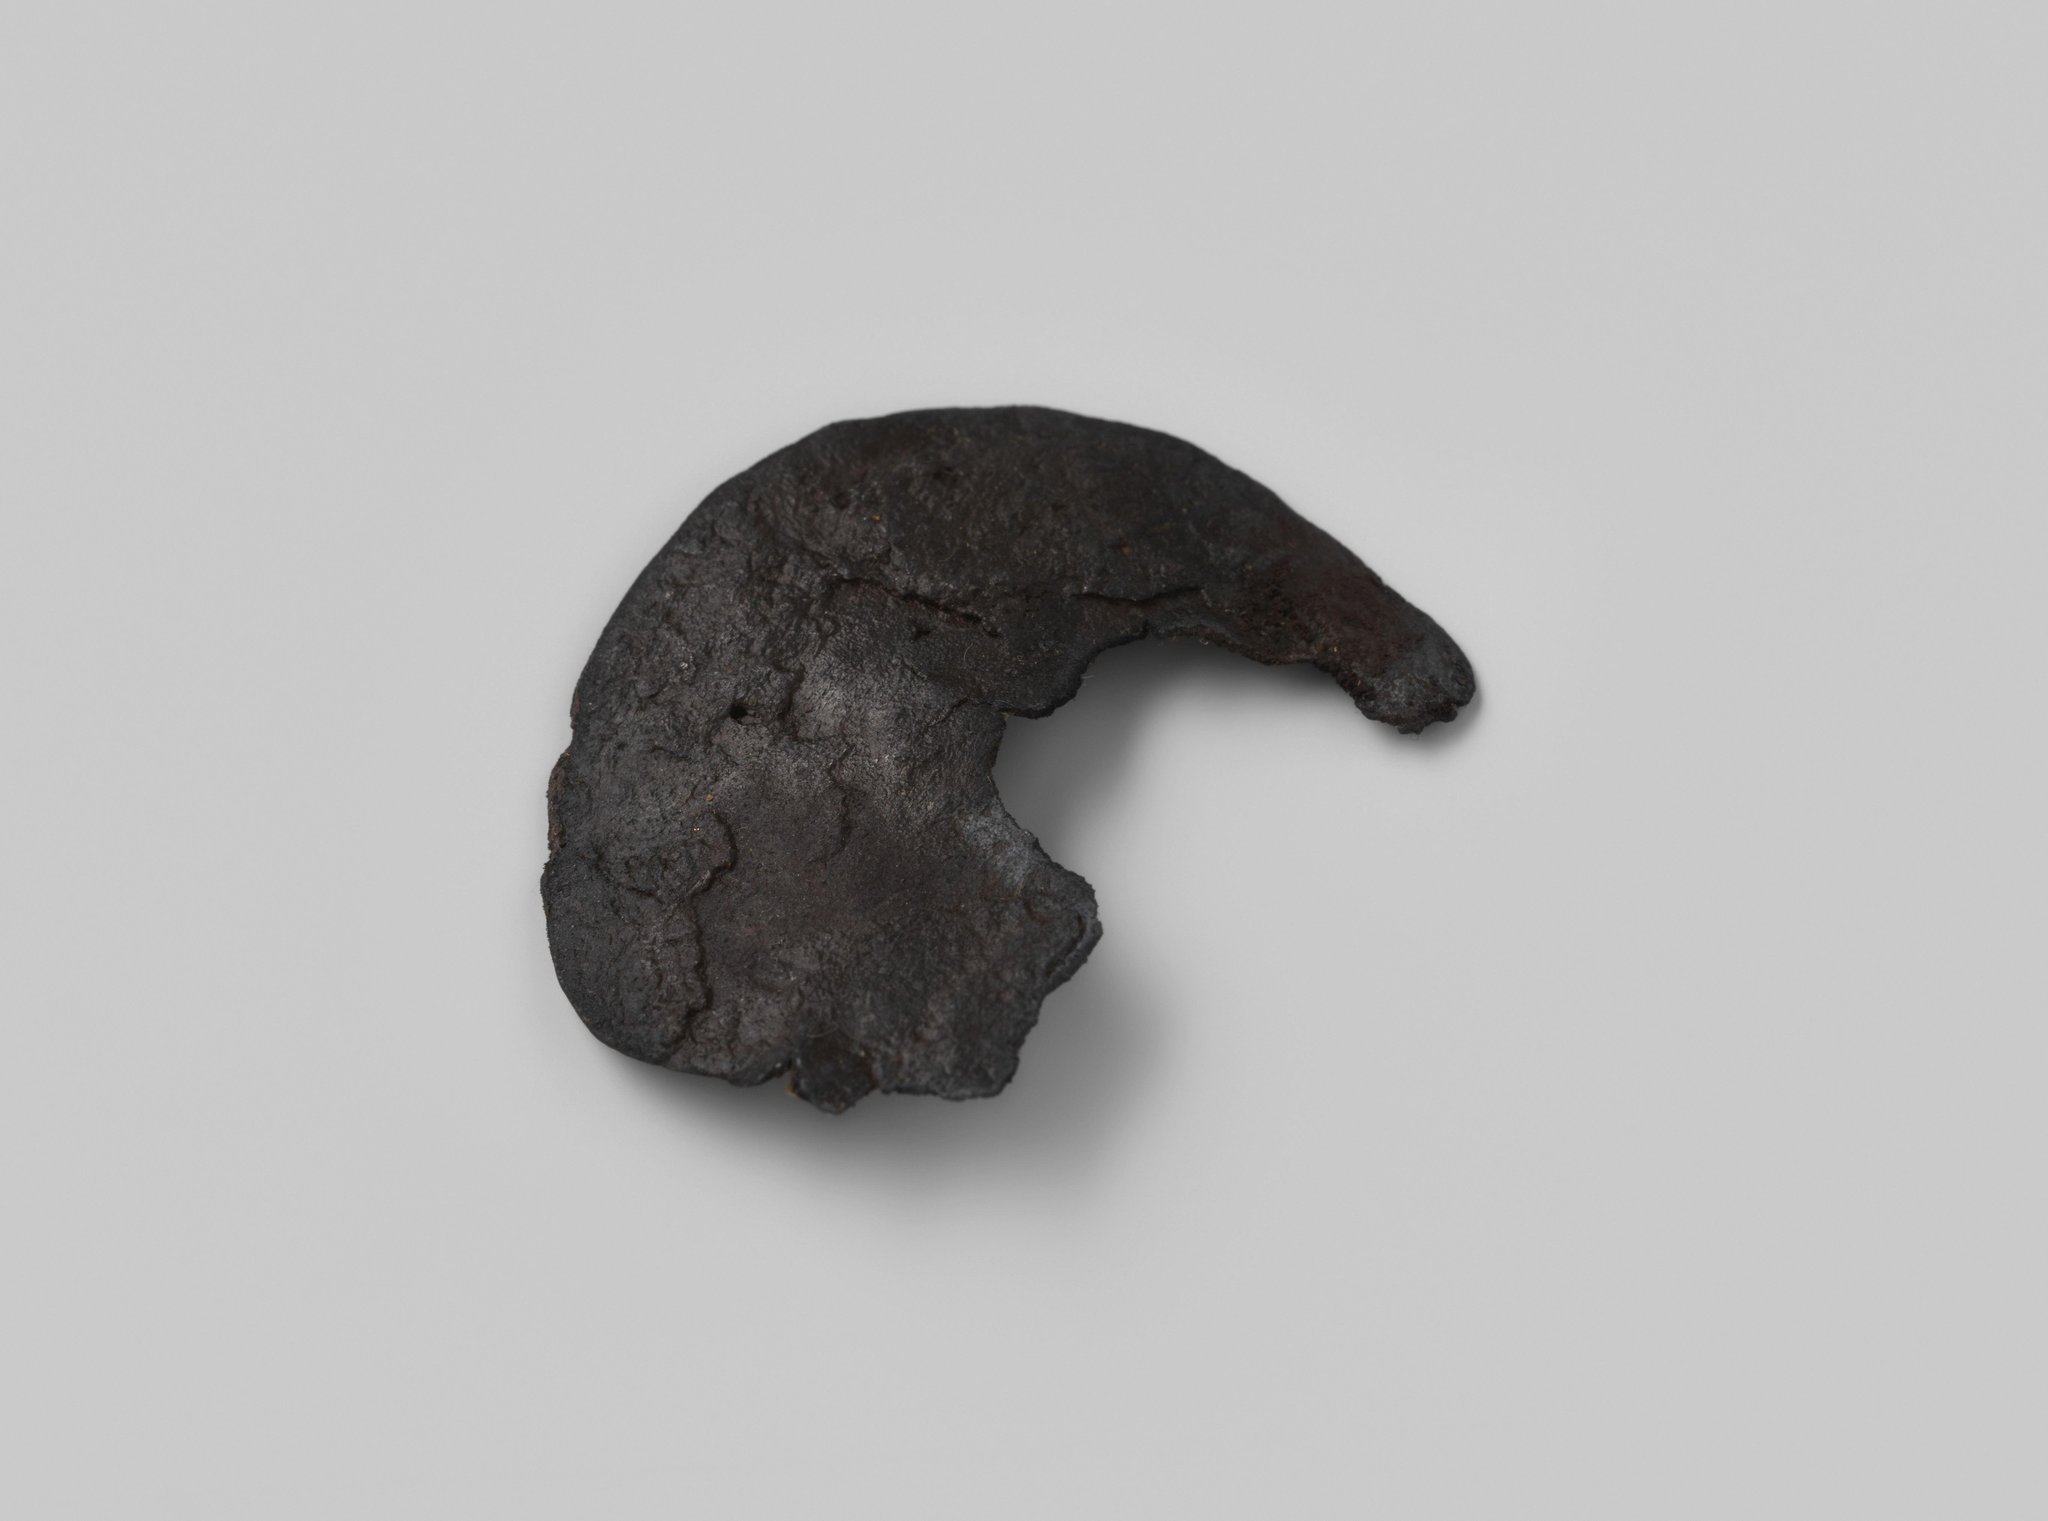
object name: fragment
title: Fragment schijfvormig object uit het wrak van de Oost-Indiëvaarder Hollandia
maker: Anonymous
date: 1700-1743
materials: silver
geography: netherlands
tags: verenigde oostindische compagnie, hollandia (schip), annet